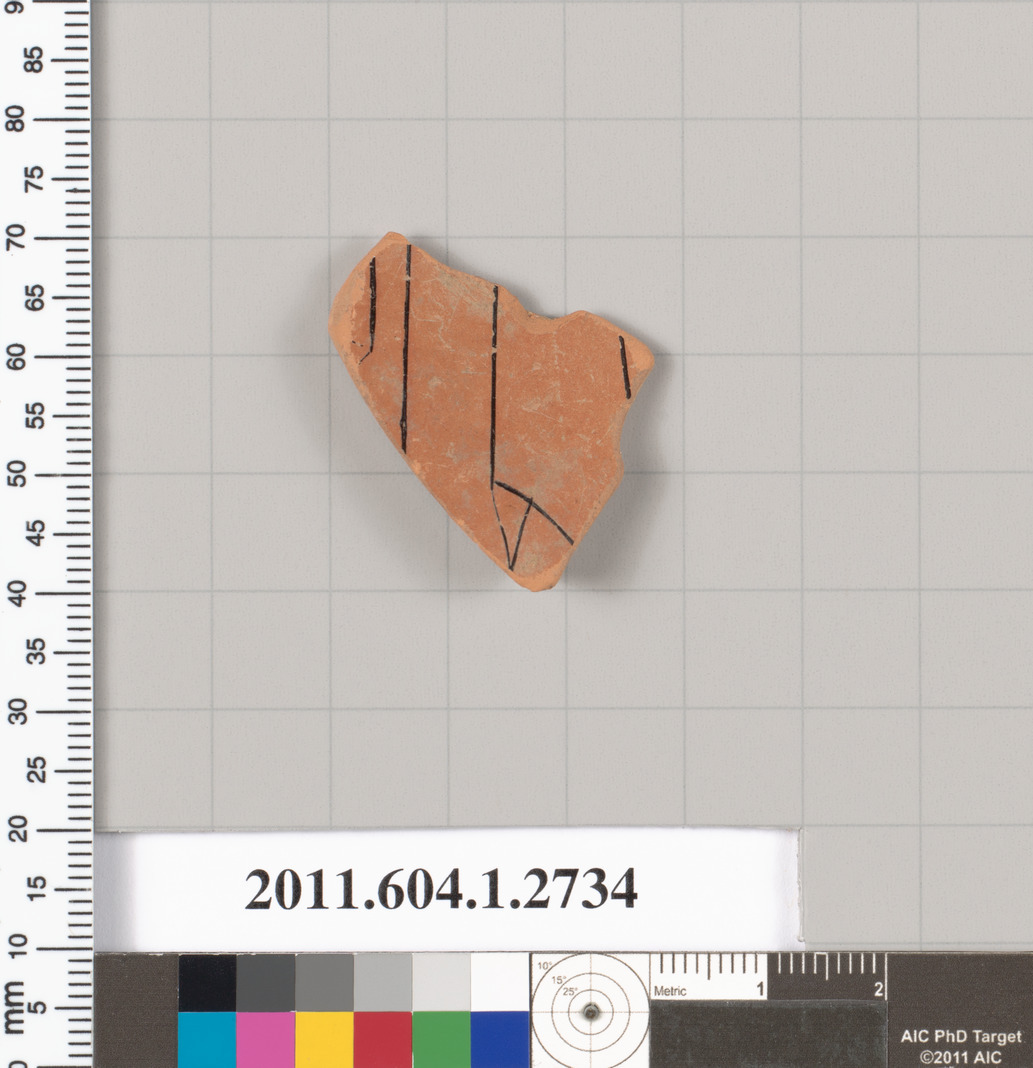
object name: kylix fragment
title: Terracotta fragment of a kylix (drinking cup)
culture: greek, attic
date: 475-451 BCE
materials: terracotta